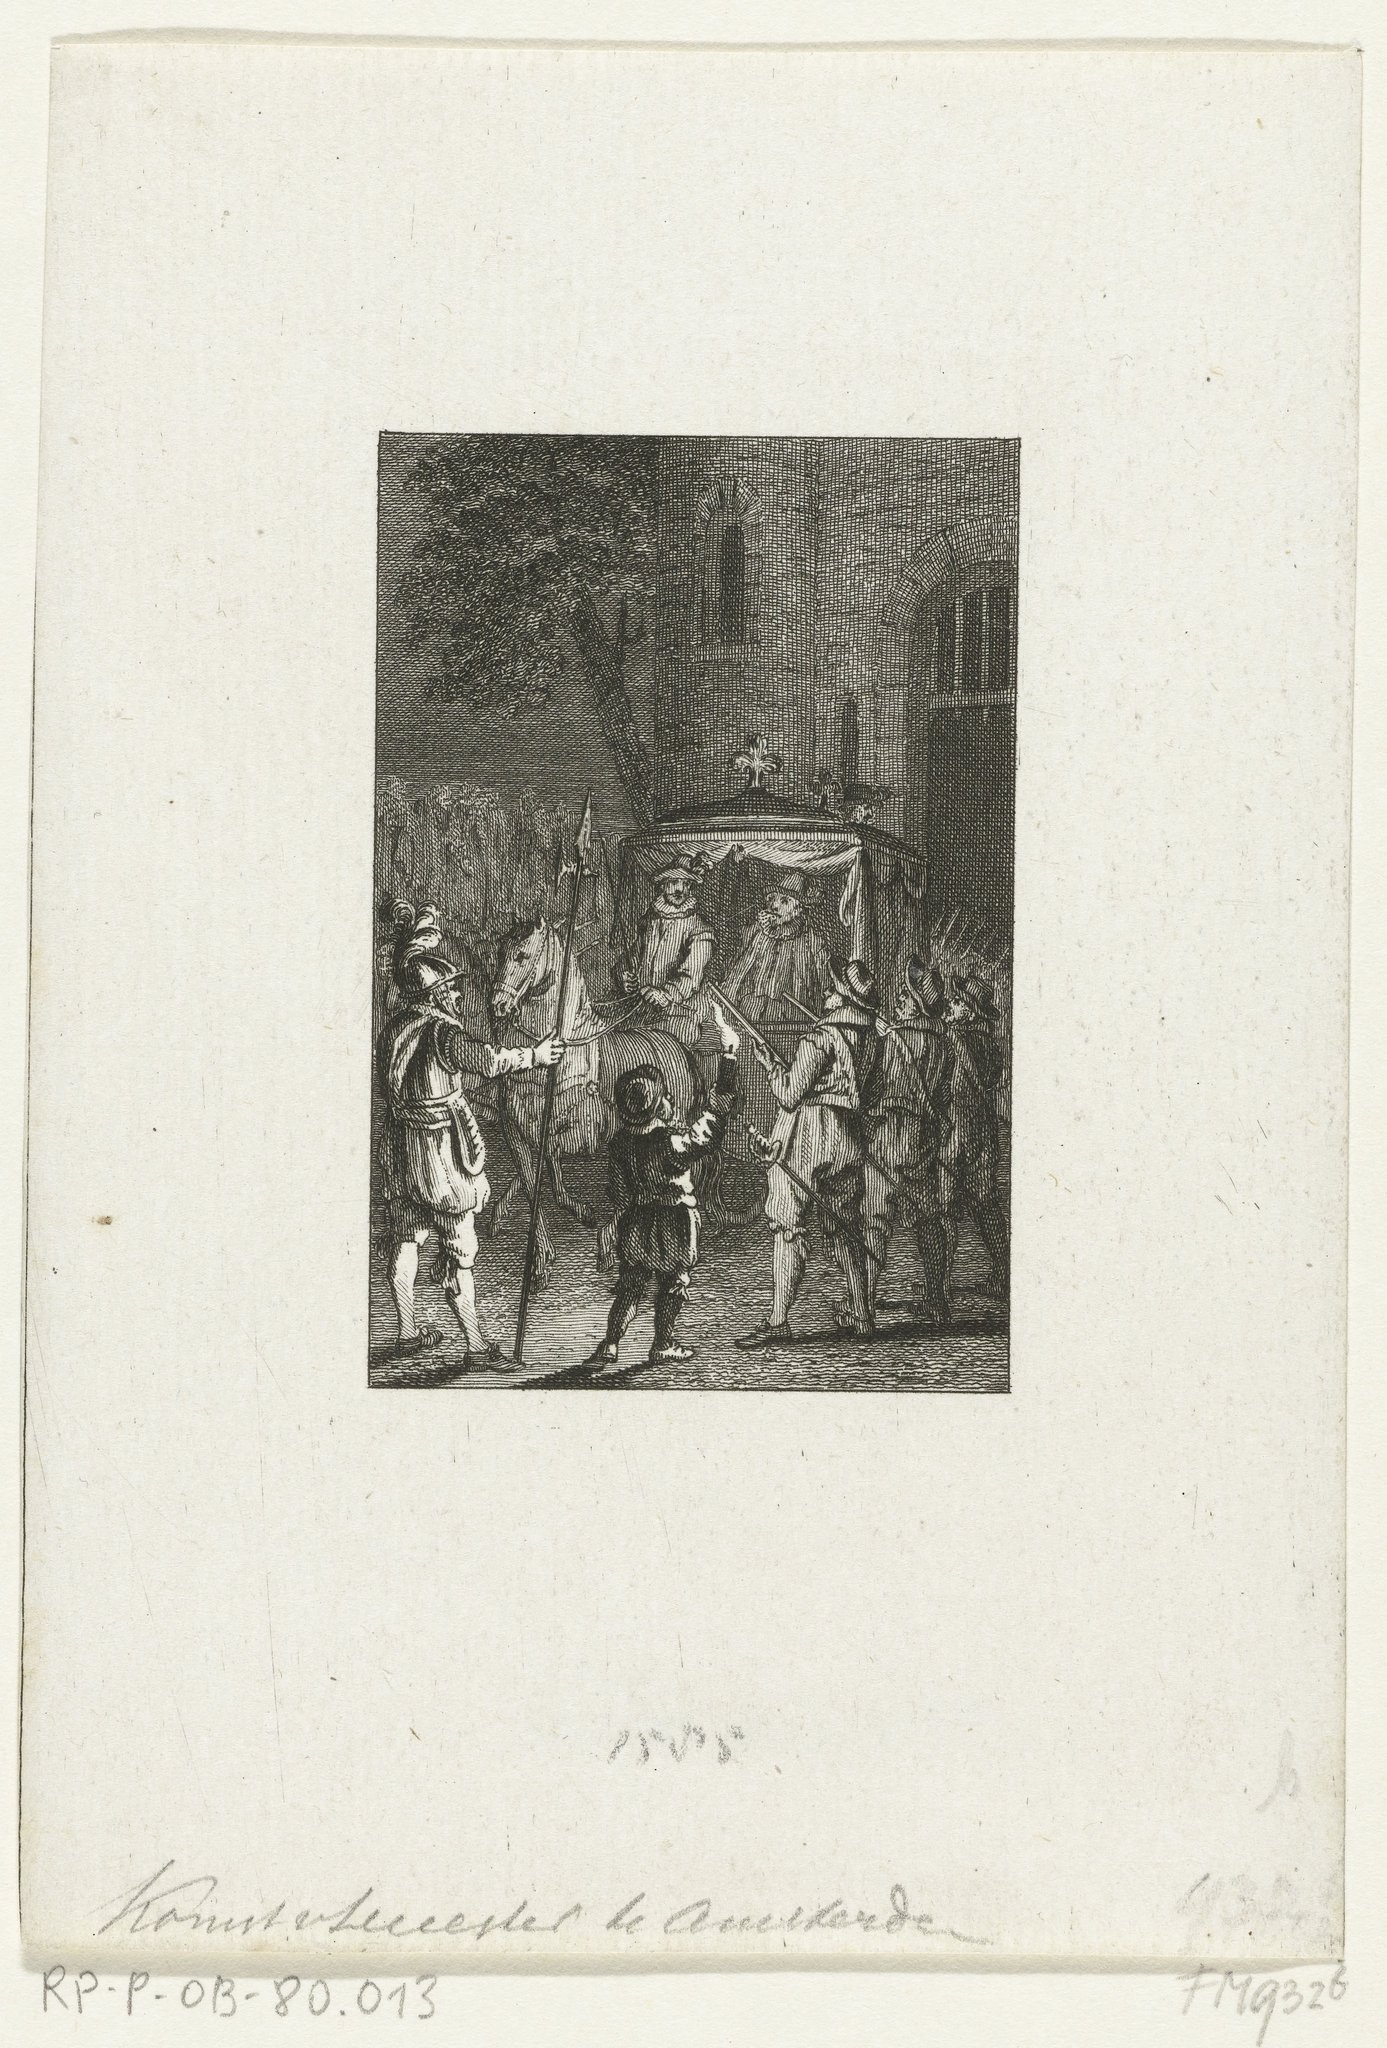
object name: history print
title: De aankomst van de graaf van Leicester te Amsterdam, 1585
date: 1780-1795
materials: paper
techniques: etching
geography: netherlands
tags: robert dudley (1st earl of leicester), amsterdam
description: Gebruikt als illustratie in: J. Fokke, Geschiedenissen der Vereenigde Nederlanden voor de vaderlandsche jeugd, Johannes Allart, Amsterdam 1783-1795, 25 delen, dl. VI, pl. II.